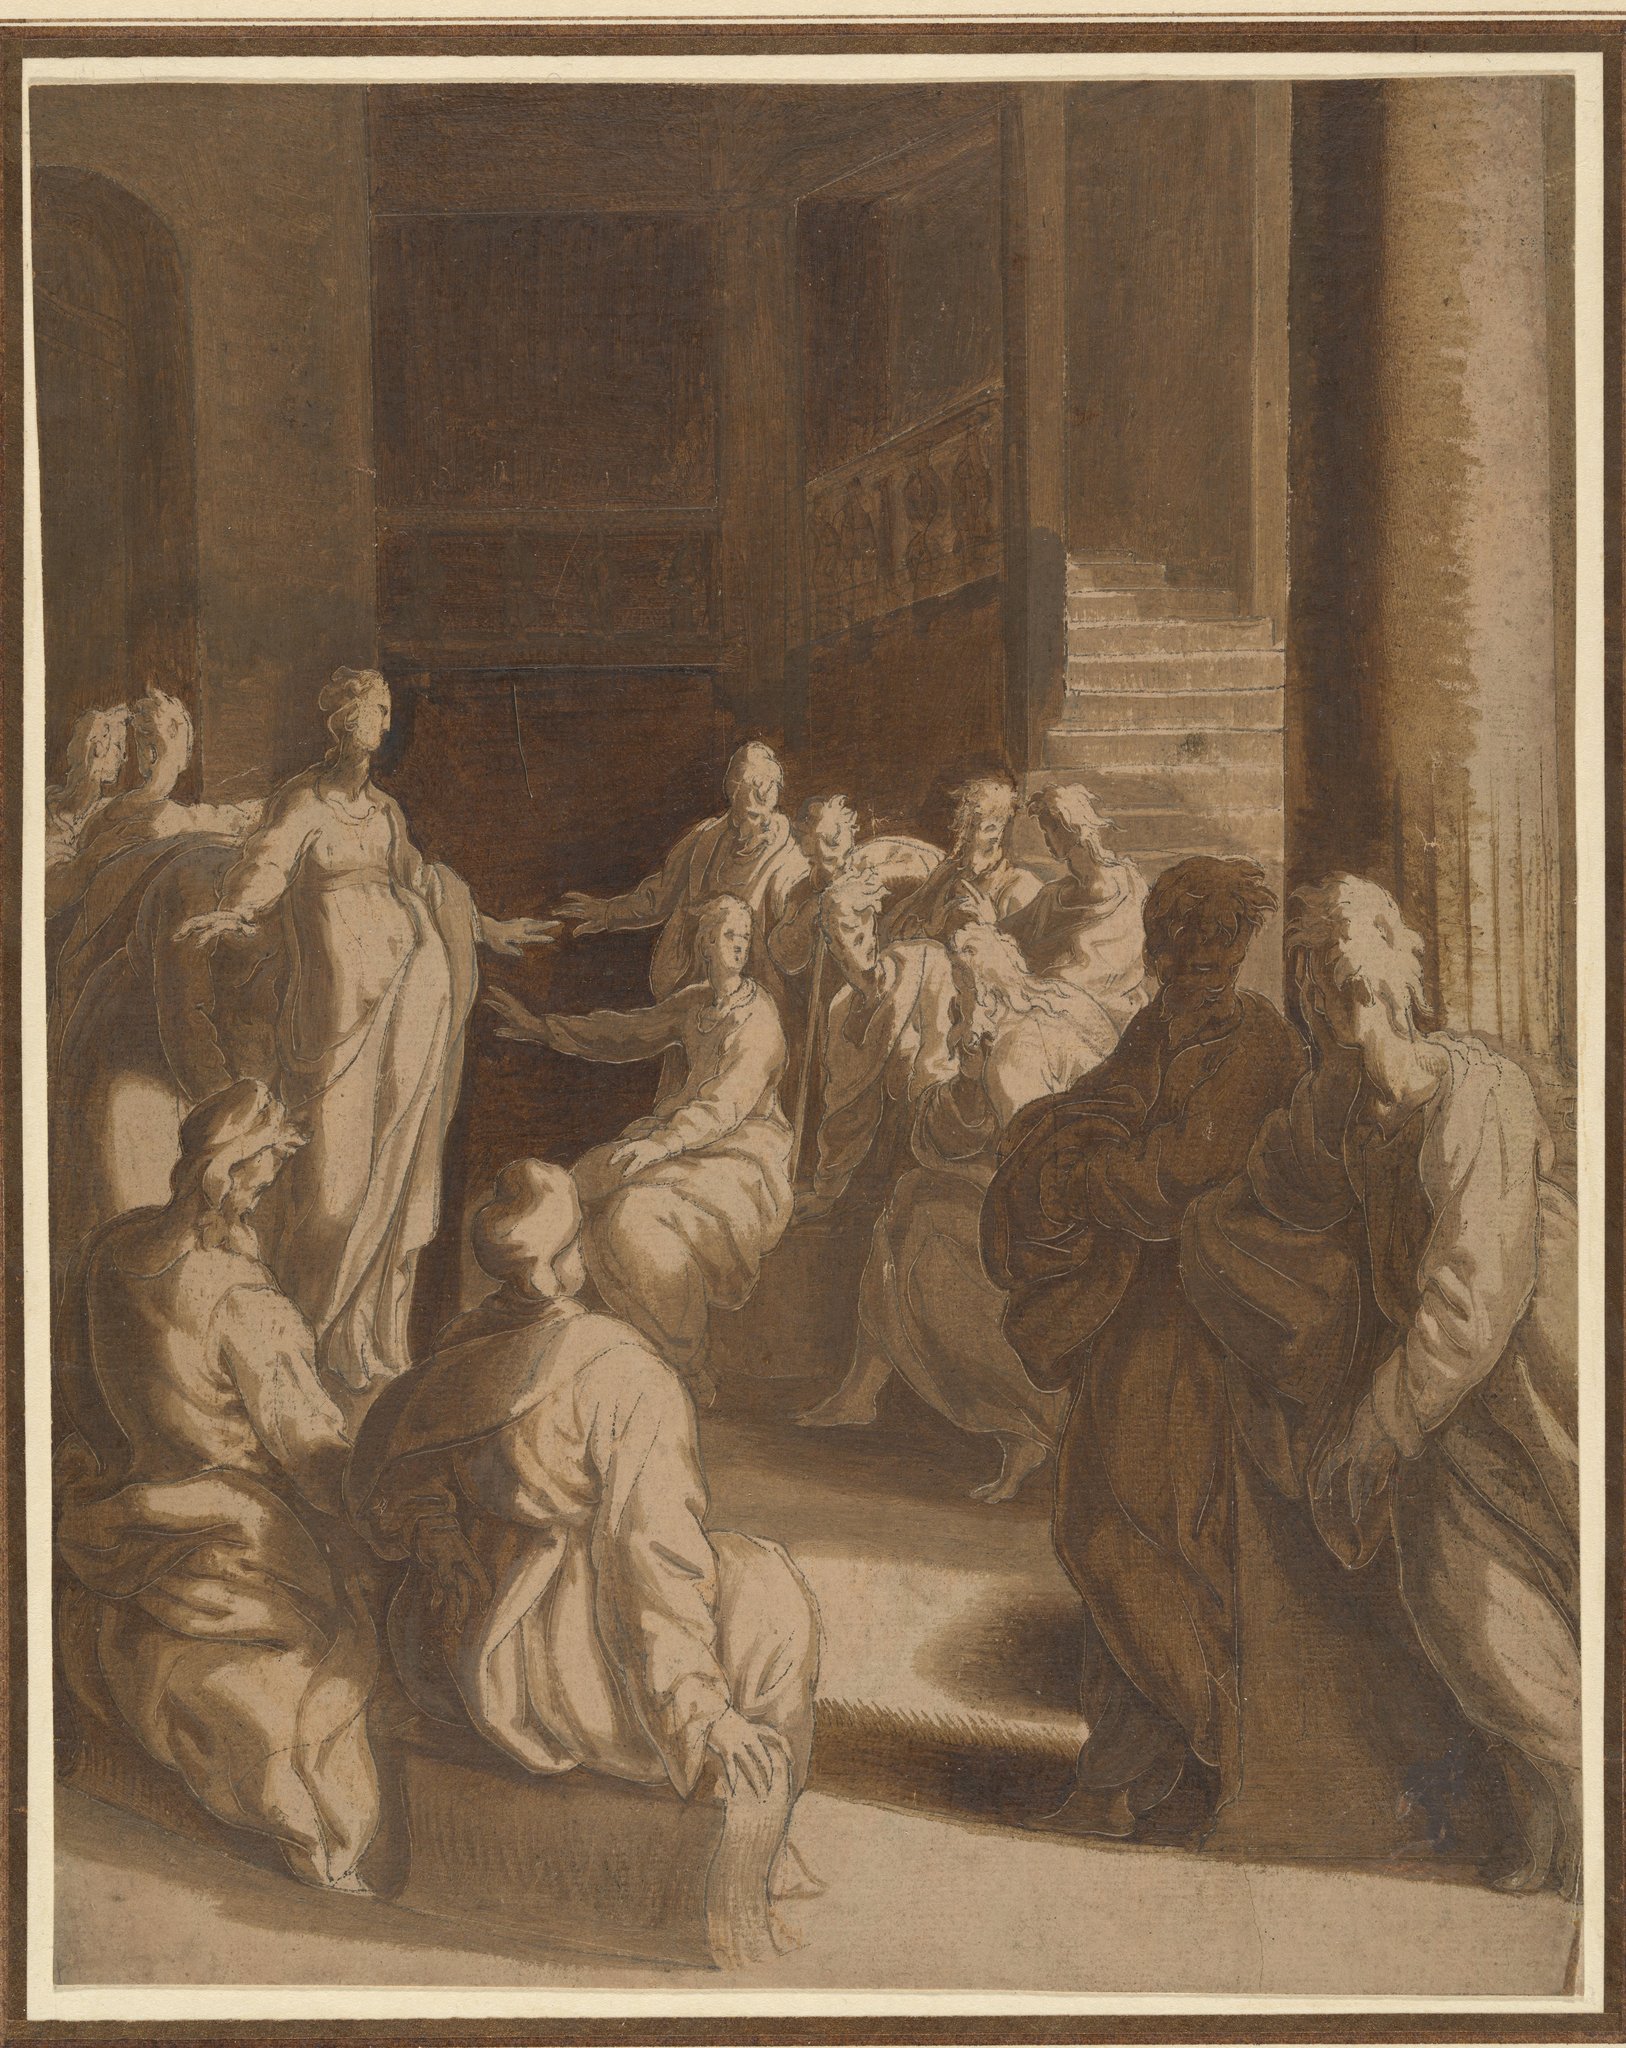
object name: drawing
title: Christ among the Doctors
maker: adriaan de weerdt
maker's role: draughtsman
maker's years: 1510-1590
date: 1573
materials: chalk, oil, paper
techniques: brush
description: Jesus became separated from his parents during celebrations for Passover. Mary (seen at left) finally found him three days later at the Temple in Jerusalem, engaged in conversation with the Scribes. De Weerdt placed the young boy at the centre of the composition, surrounded by onlookers astounded by the boy’s wisdom.